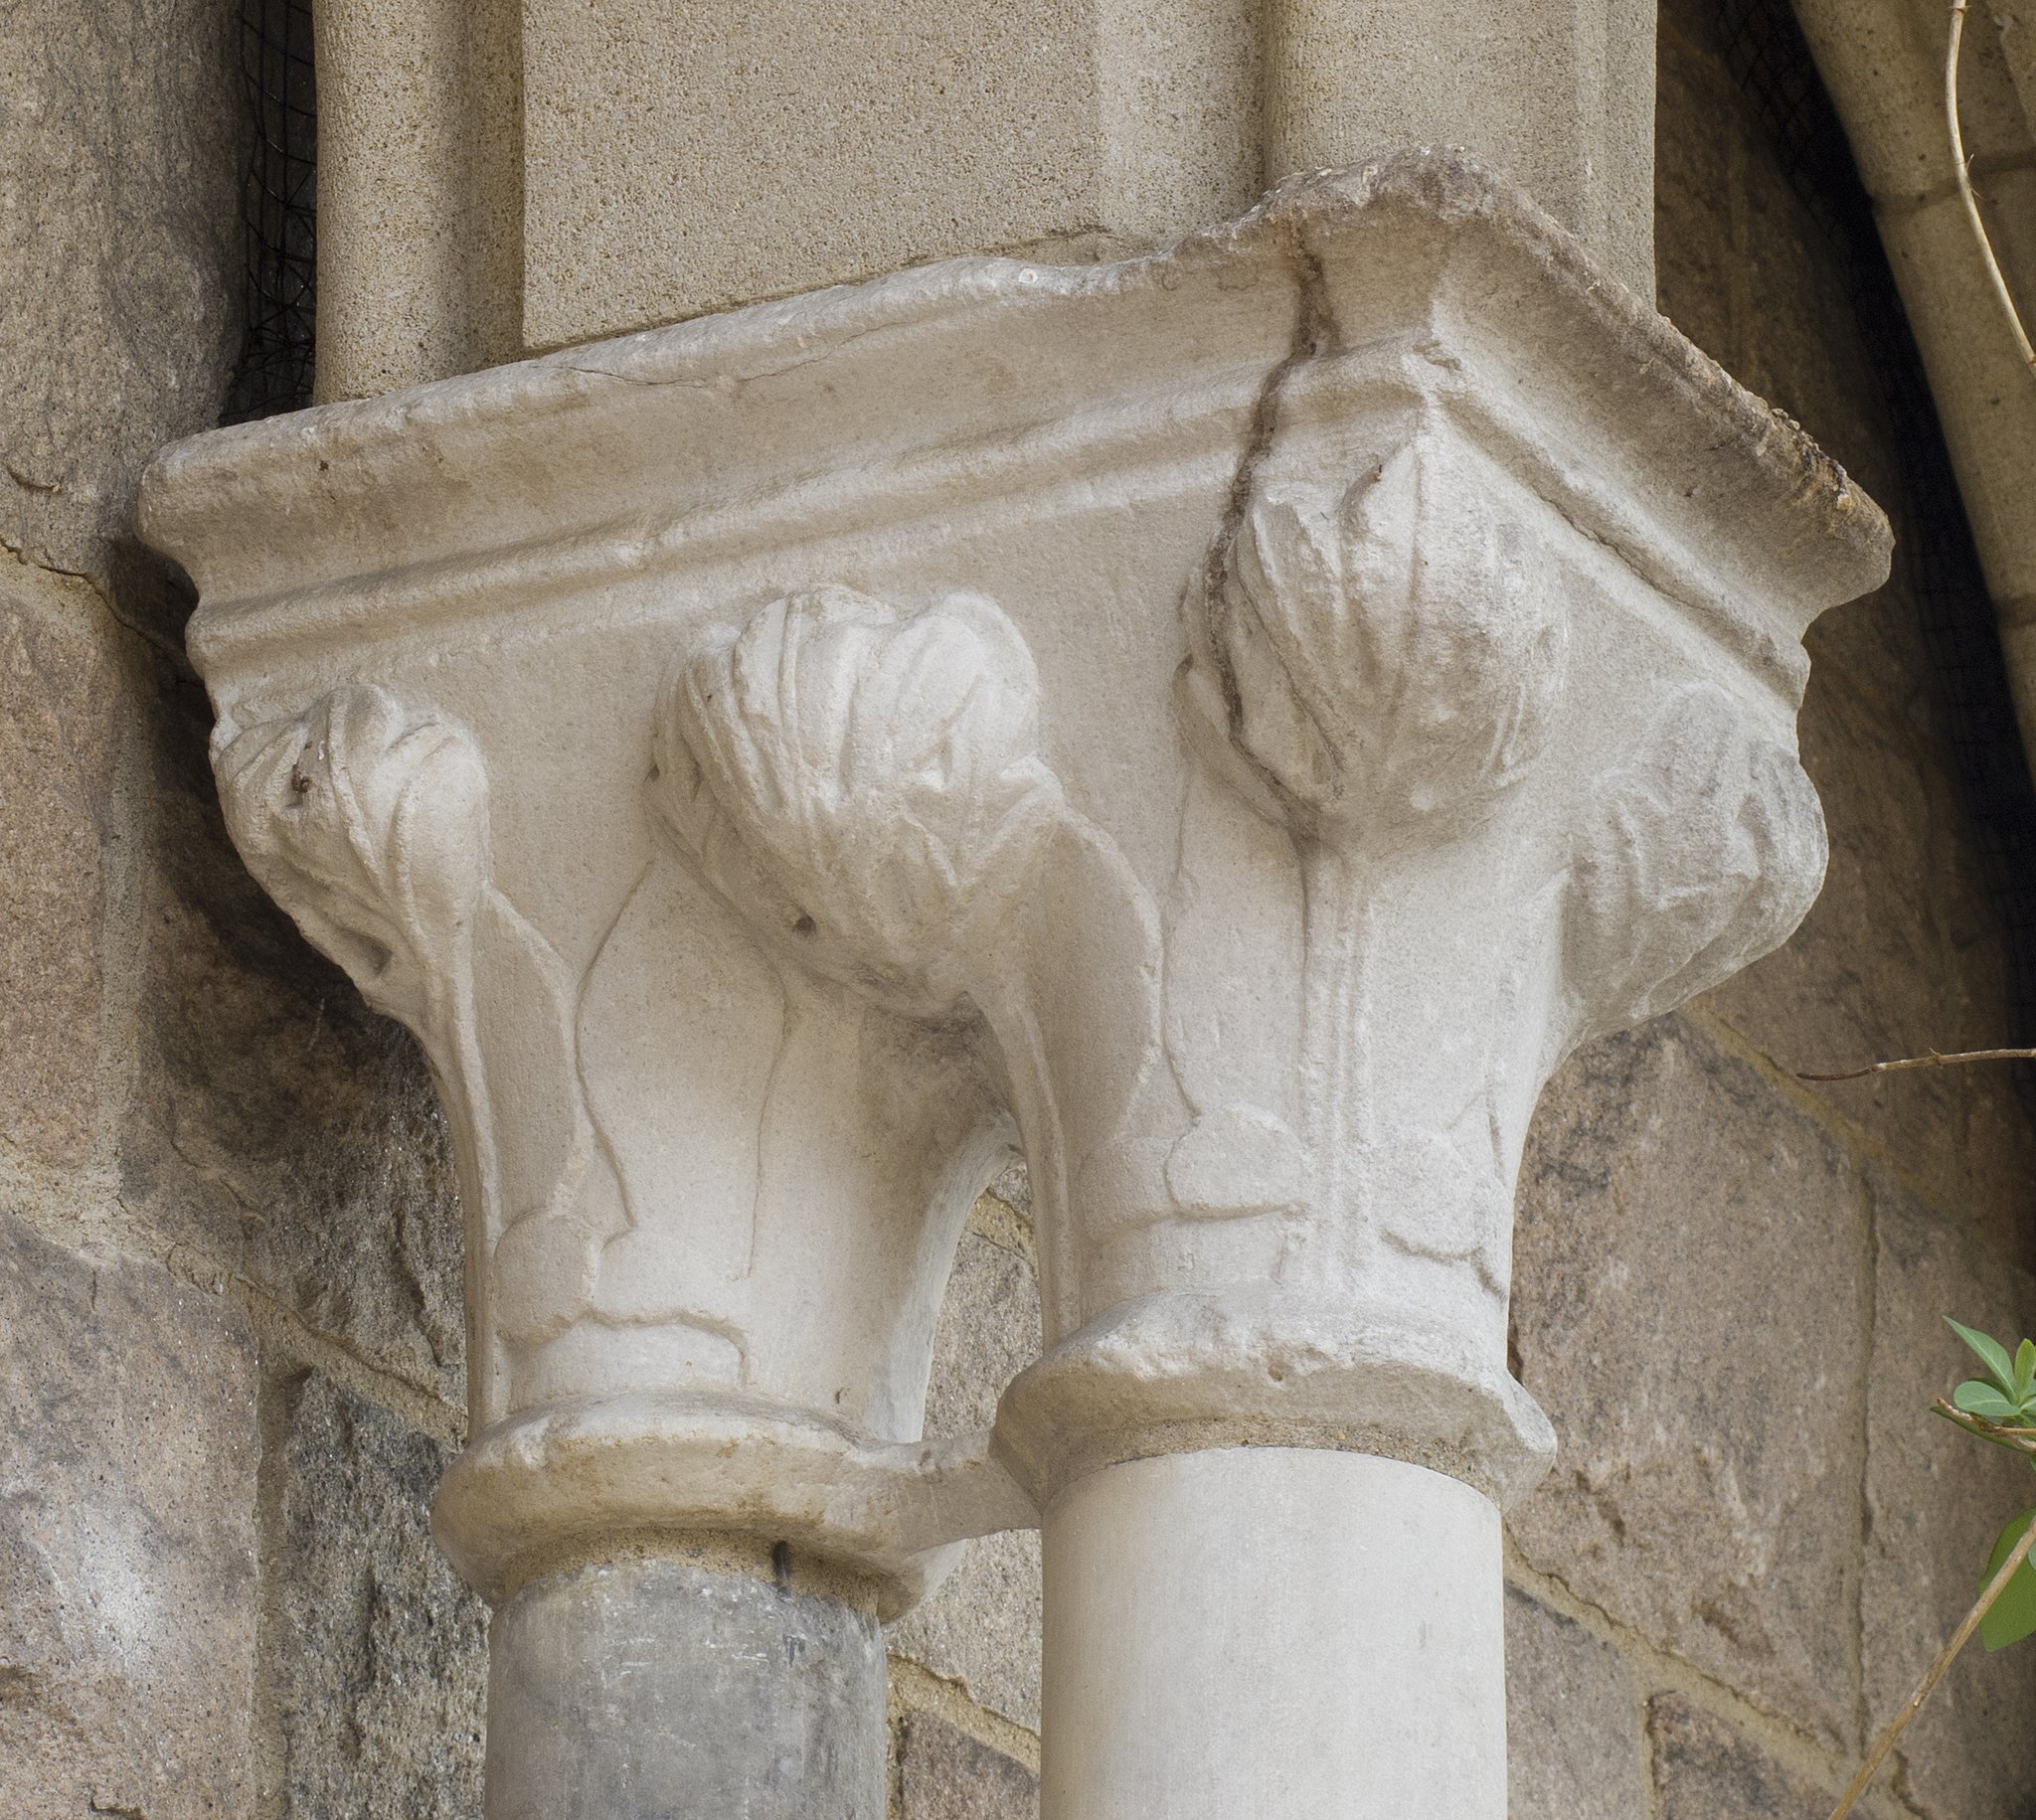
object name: capital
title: Double Capital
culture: french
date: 1267-1333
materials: marble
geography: france